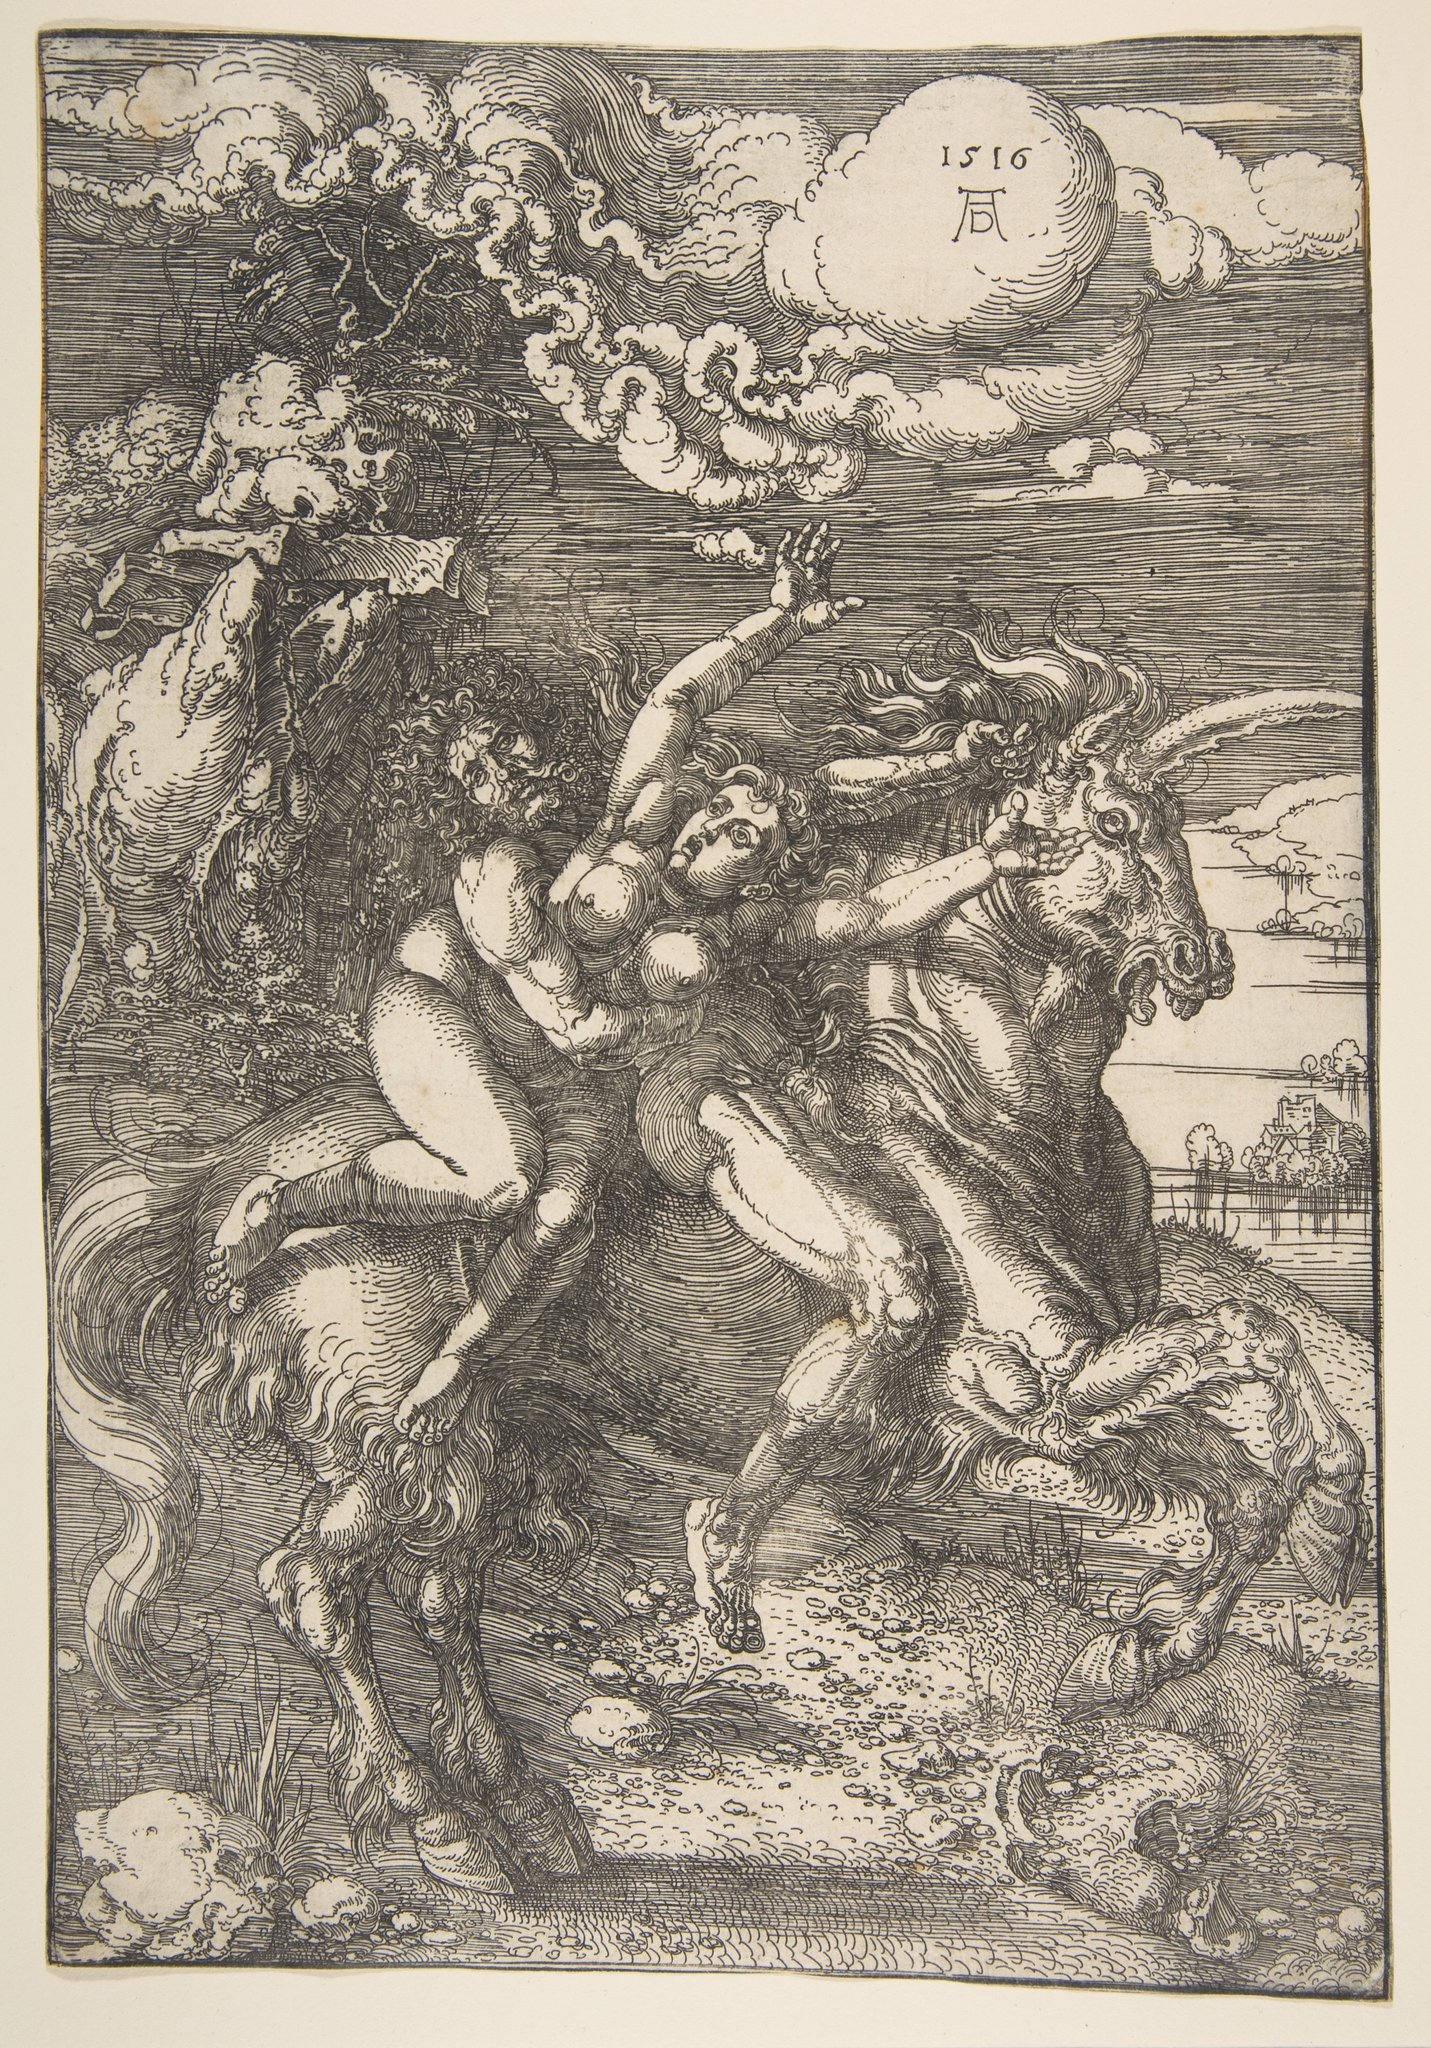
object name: print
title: Abduction of Proserpine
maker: albrecht dürer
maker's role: artist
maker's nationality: german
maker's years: 1471-1528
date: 1516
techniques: etching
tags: mythology,men,female nudes,horses